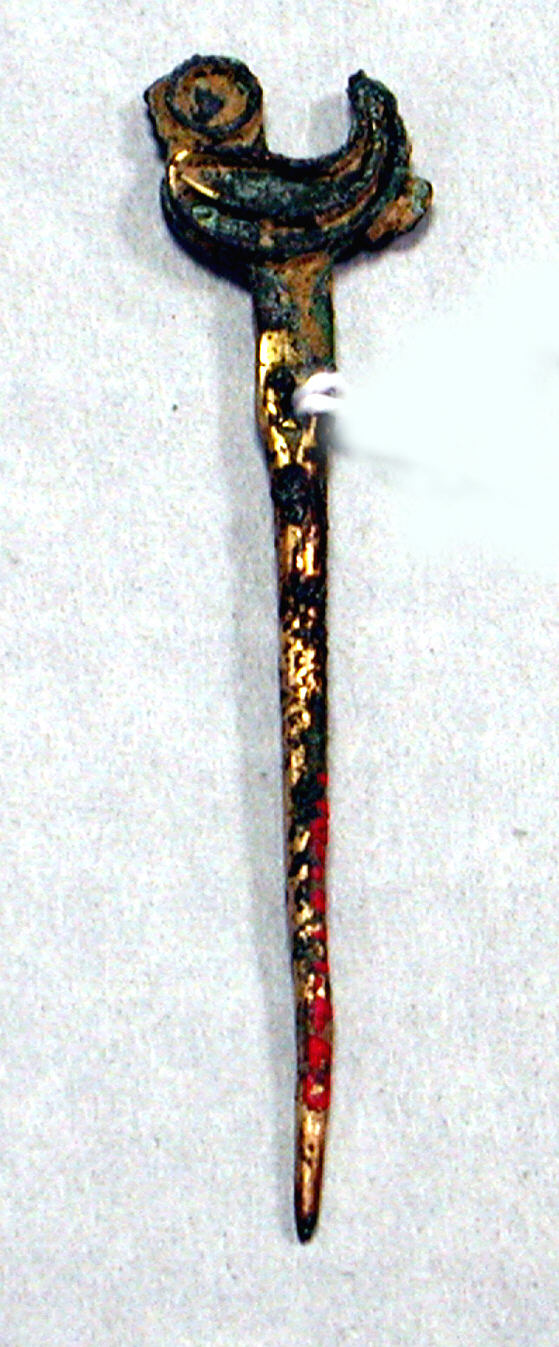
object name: pin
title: Copper Pin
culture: inca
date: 1401-1600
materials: copper, gilt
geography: peru